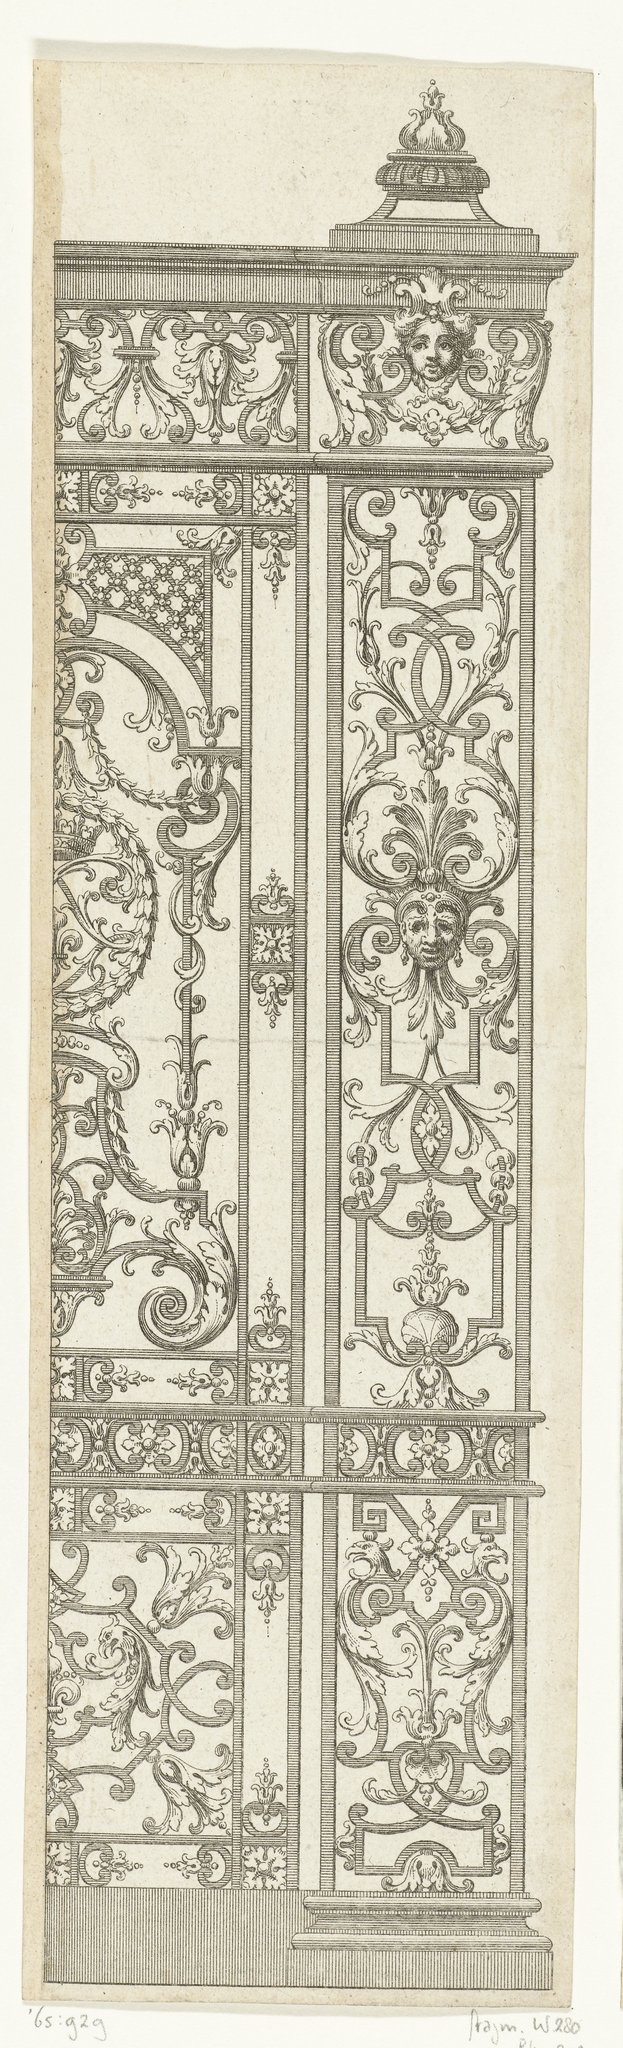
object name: ornament print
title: Ontwerpen voor poorten en leuningen van smeedijzer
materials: paper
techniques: etching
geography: france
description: In de poort zitten twee maskers verwerkt. Fragment van blad 1 uit serie van 5 bladen. Tweede editie.